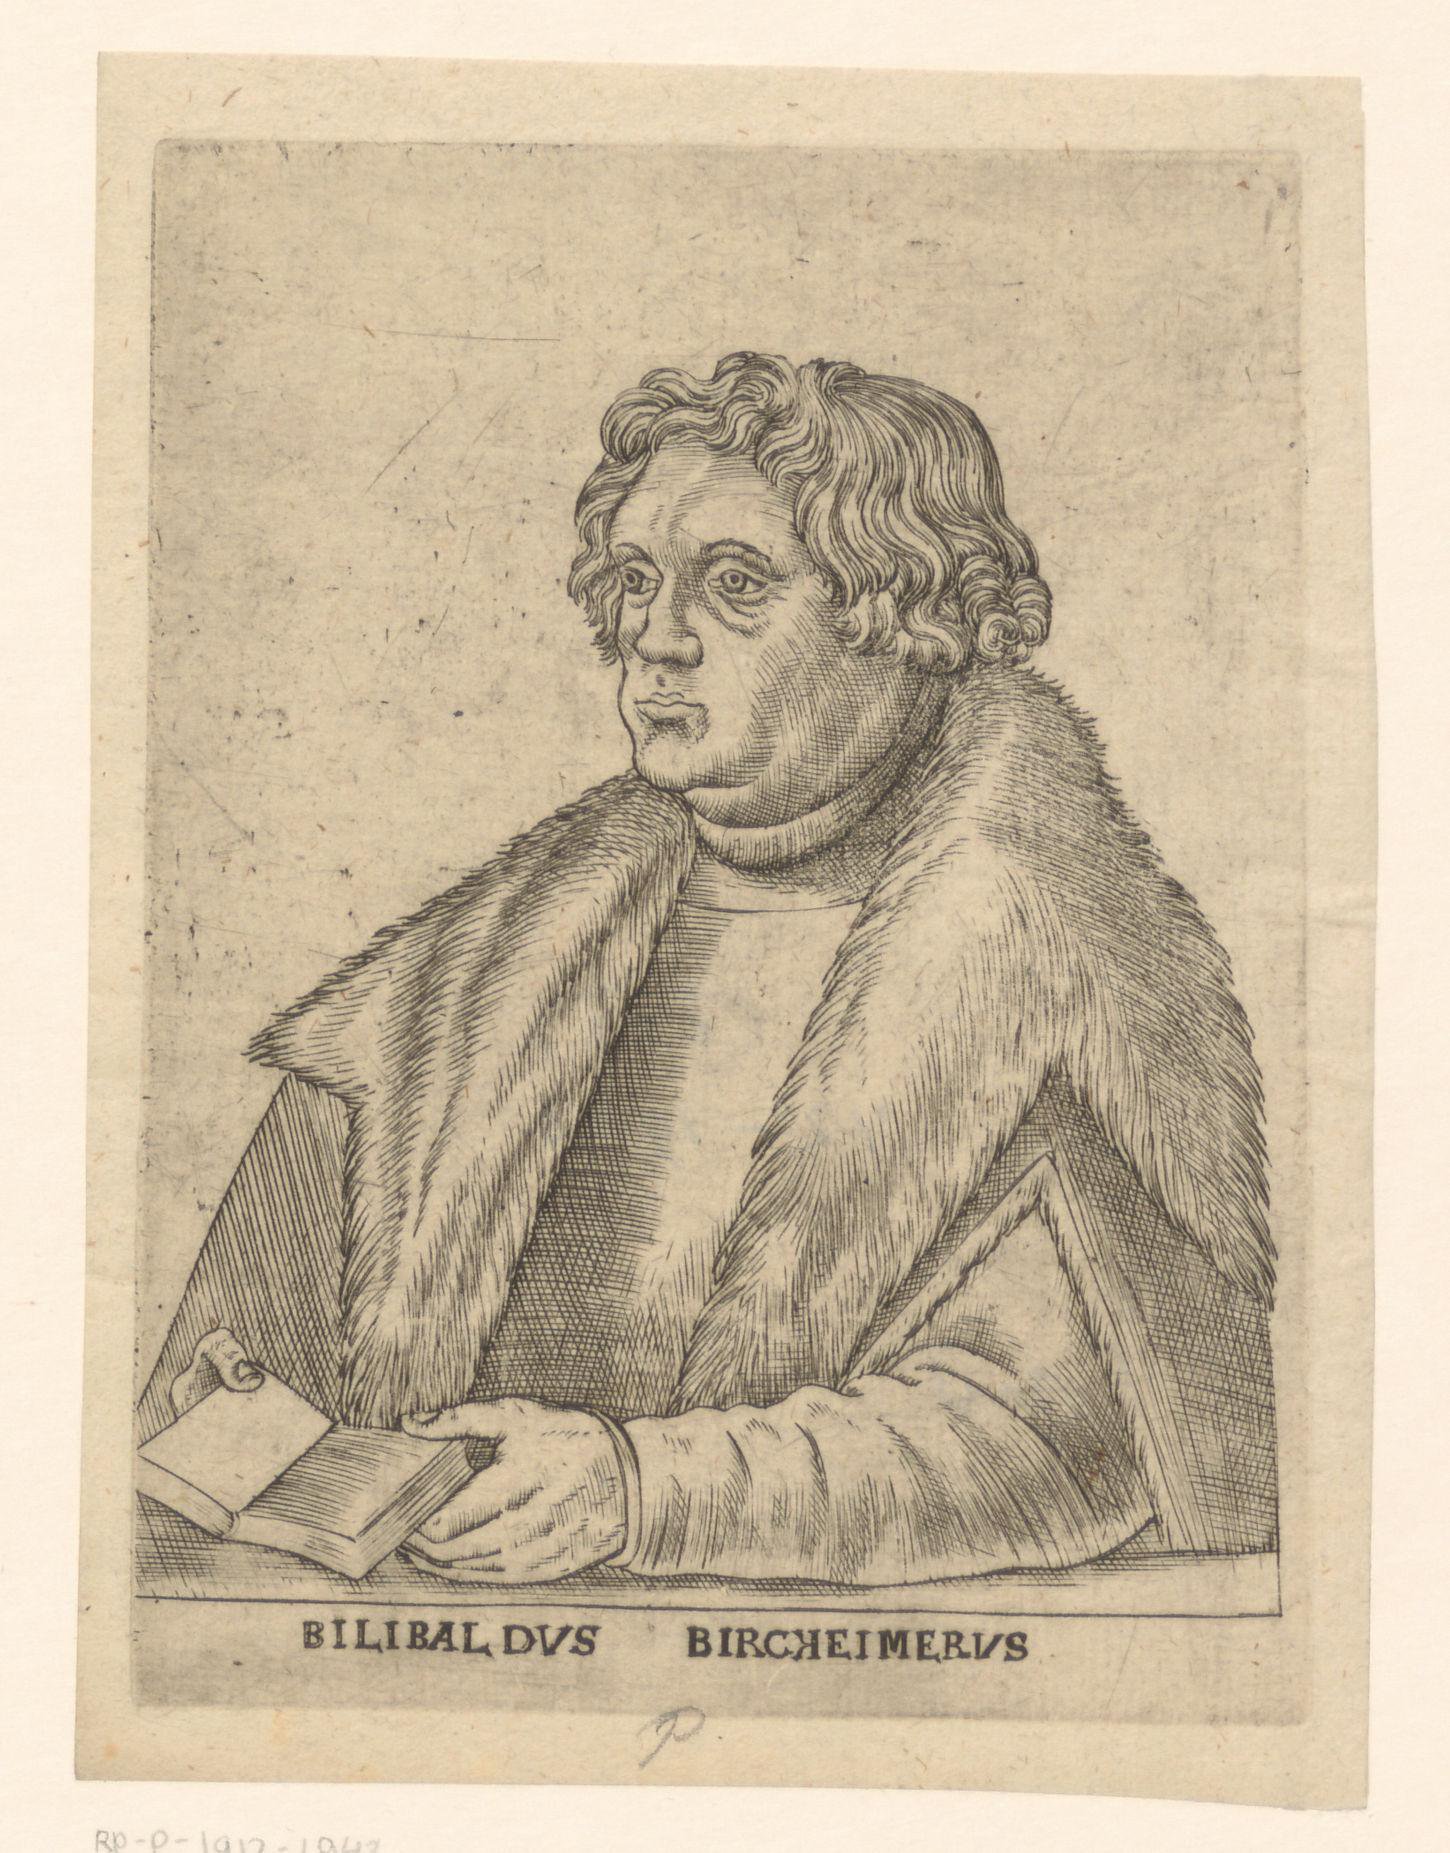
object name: print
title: Portret van Bilibald Prickheimer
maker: Anonymous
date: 1563-1642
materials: paper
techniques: engraving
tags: willibald pirckheimer, historical persons, portrait of a writer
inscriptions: collector's mark: Lugt 2228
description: Deze prent (een impressie) hoort bij een serie portretten van sturende personen tijdens de reformatie.